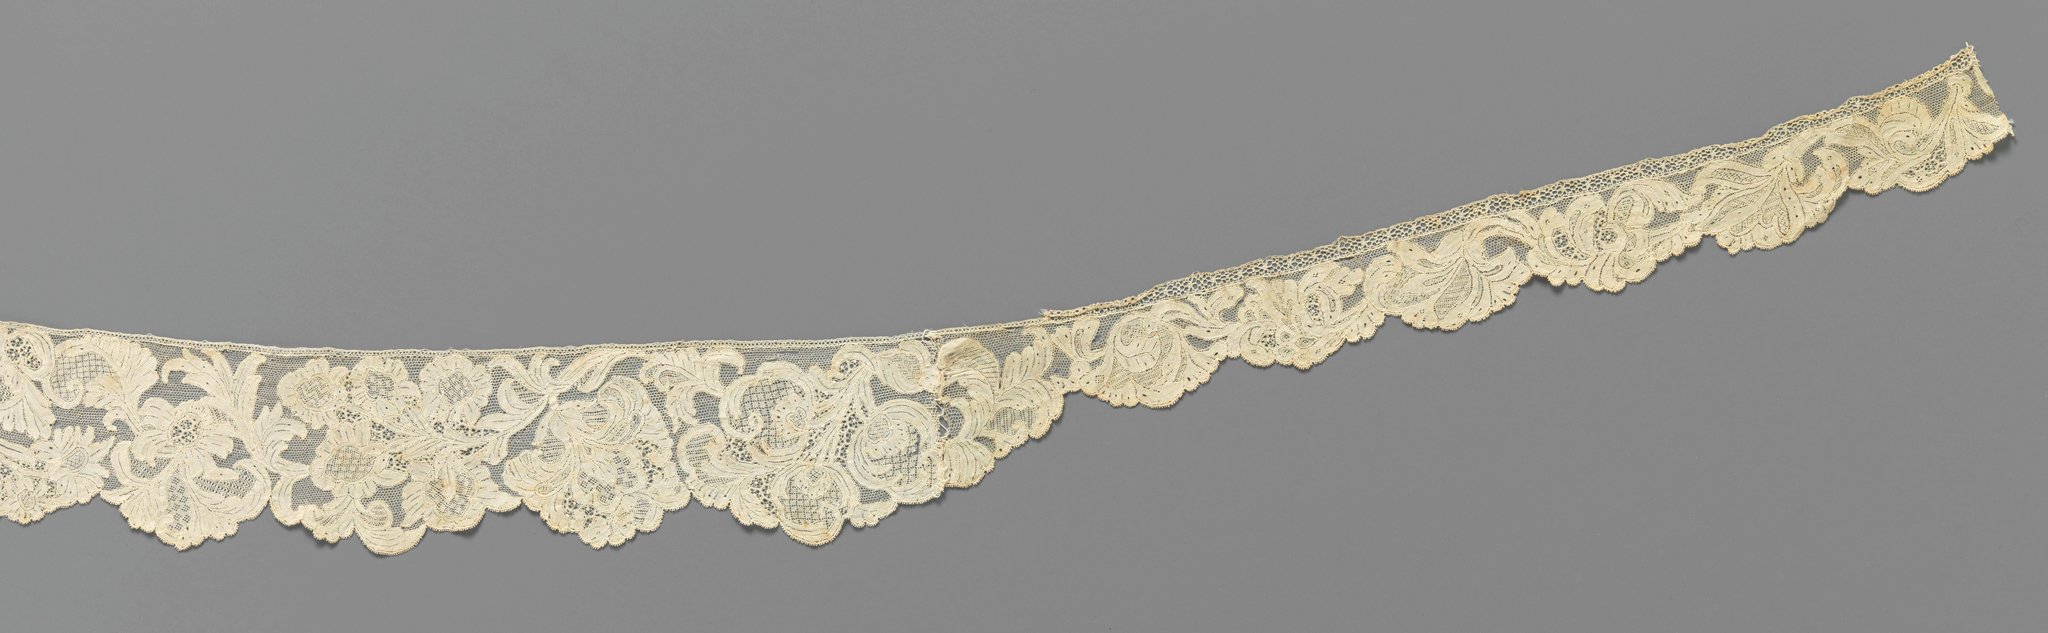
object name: engageante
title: Engageante van naaldkant met een symmetrisch patroon met een bloemenvaas ranken waaraan gevederde bladeren en irissen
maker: Anonymous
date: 1725-1749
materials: linen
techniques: lace, needlepoint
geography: brussels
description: Engageante van naturelkleurige naaldkant: platte Venetiaanse netgrondkant (?). Het patroon heeft een vaas met symmetrisch geschikte bloemen, geflankeerd door twee toegewende lopende ranken, waaraan grote bloemen met "huis in huis"-werk. Het patroon heeft bovendien een iris geflankeerd door trosbloemen. De motieven zijn gemaakt met ongedraaide festonsteken waartussen talloze fijne uitsparingen zijn gemaakt. Er is een iets dikkere, maar evenzeer fijne contourdraad gebruikt om patroondelen te accentueren. De motieven zijn met elkaar verbonden door een fijne maasgrond met overdwarse toeren. In en om de meeste bloemen en bladeren zijn zeer fijne siergronden toegepast in vele varianten, waaronder siergronden met ruitjes, 'patrijsogen', blokjes en zigzag-lijnen. De schulpenrand komt voort uit het patroon en is afgewerkt met picots. De bovenzijde is recht en afgewerkt met een geklost bandje. Aan de rechterzijde is de engageante verlengt met een strookje van hetzelfde type kant.